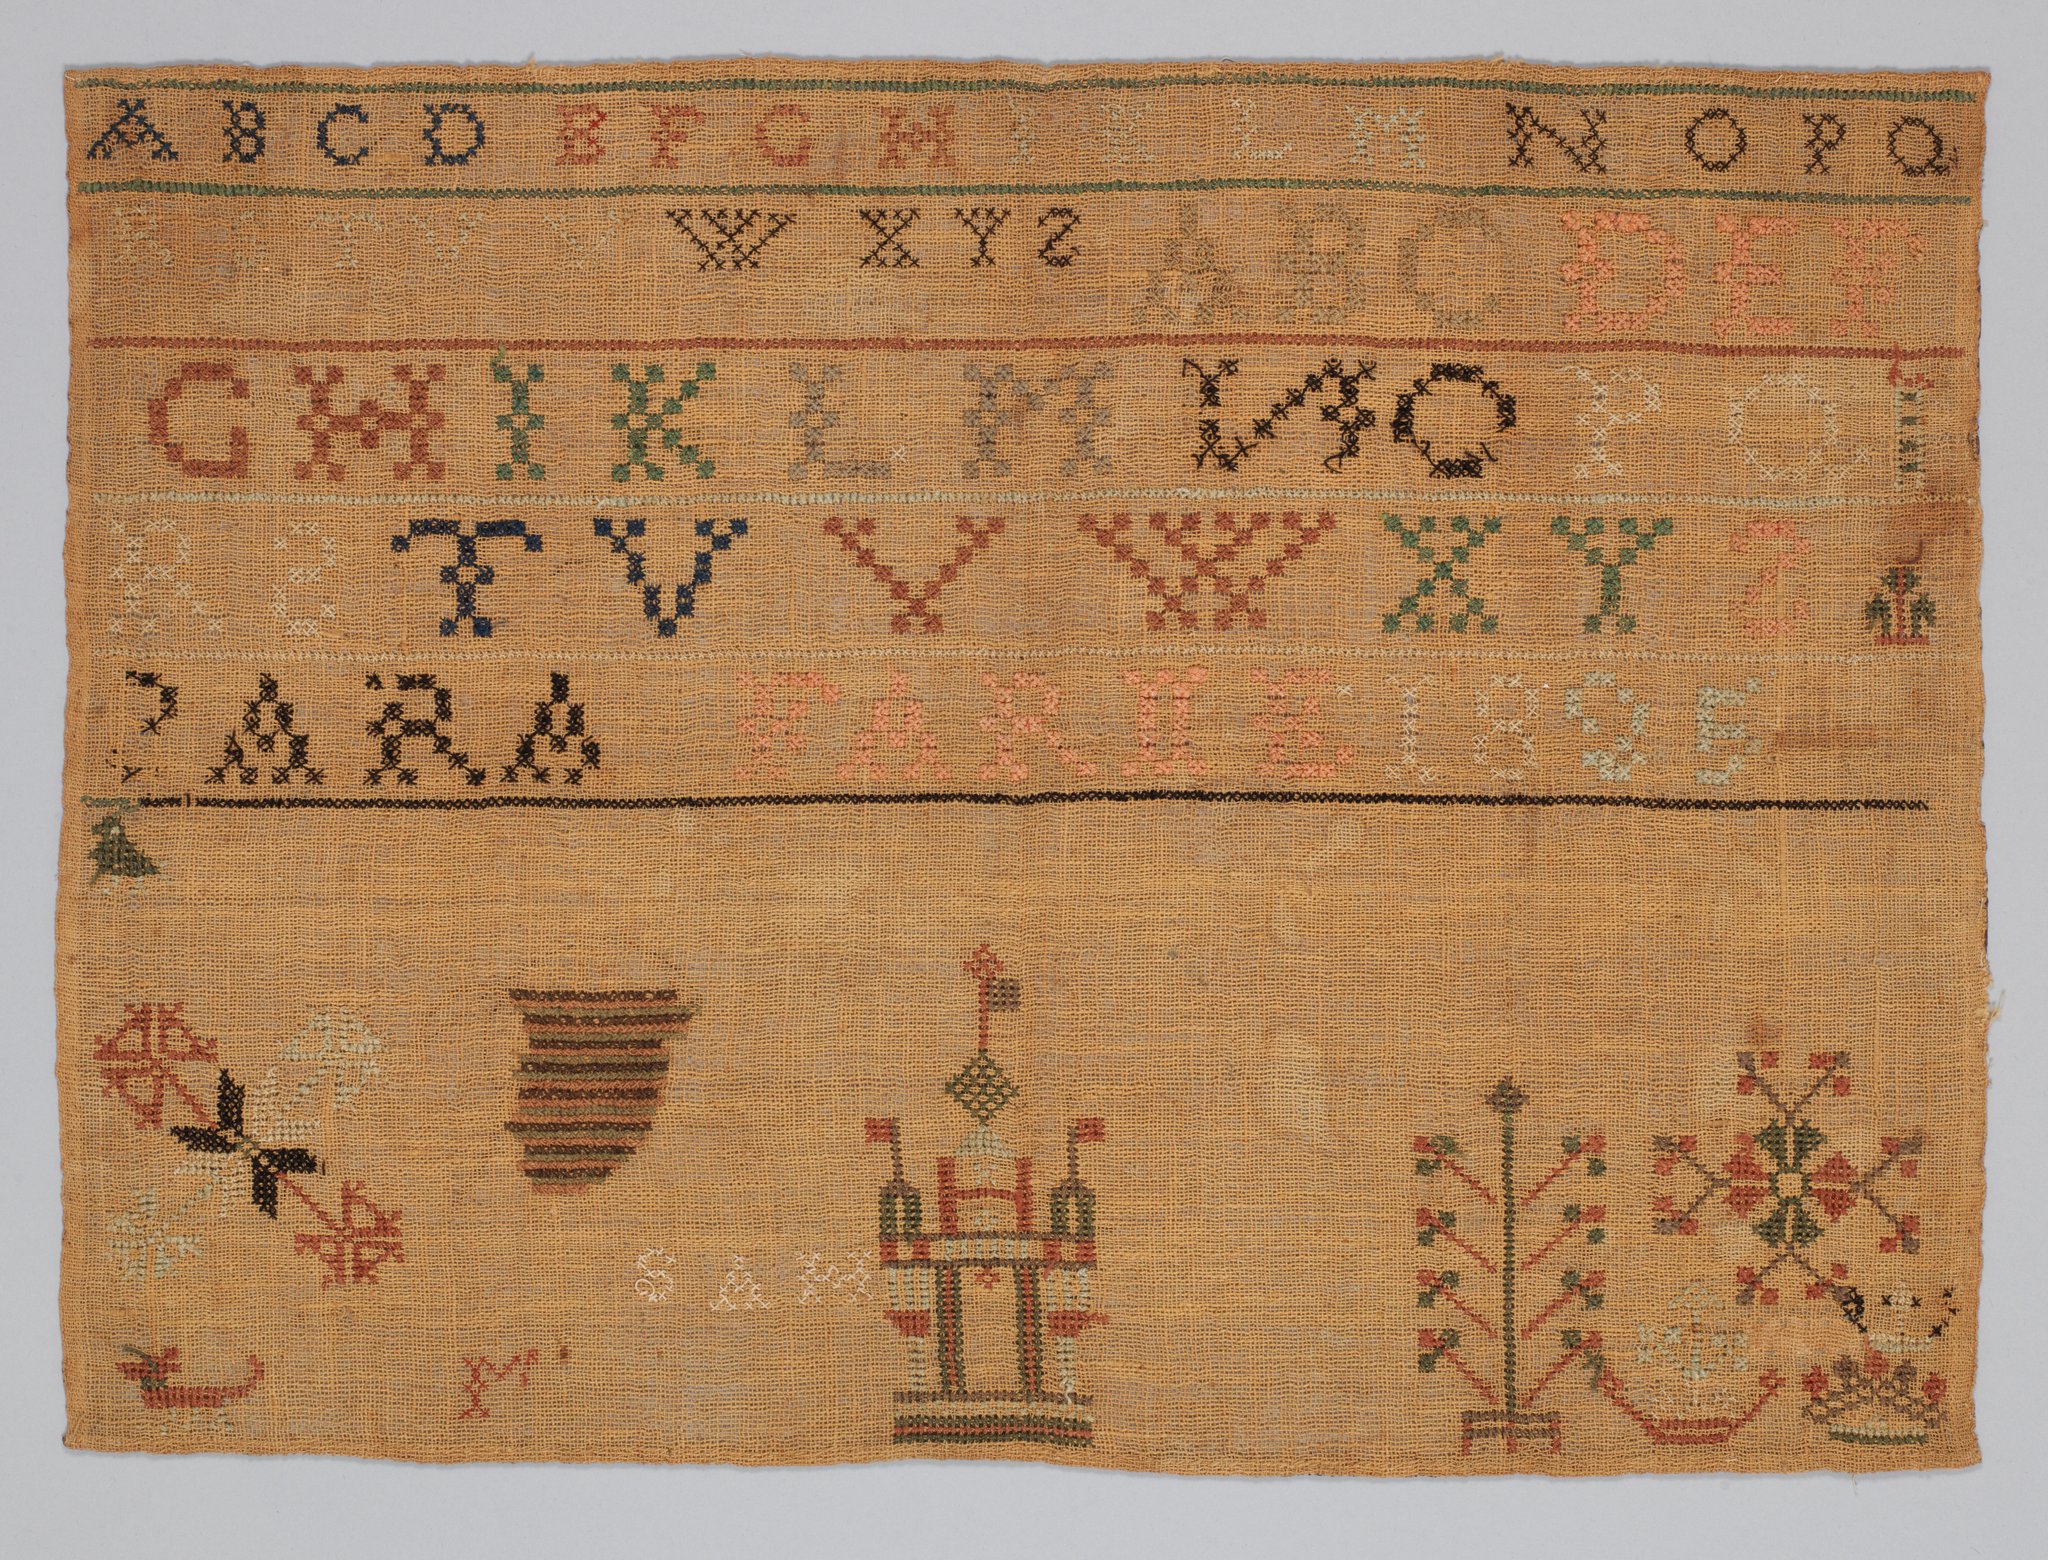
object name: sampler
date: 1825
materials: canvas, cotton, hemp, silk